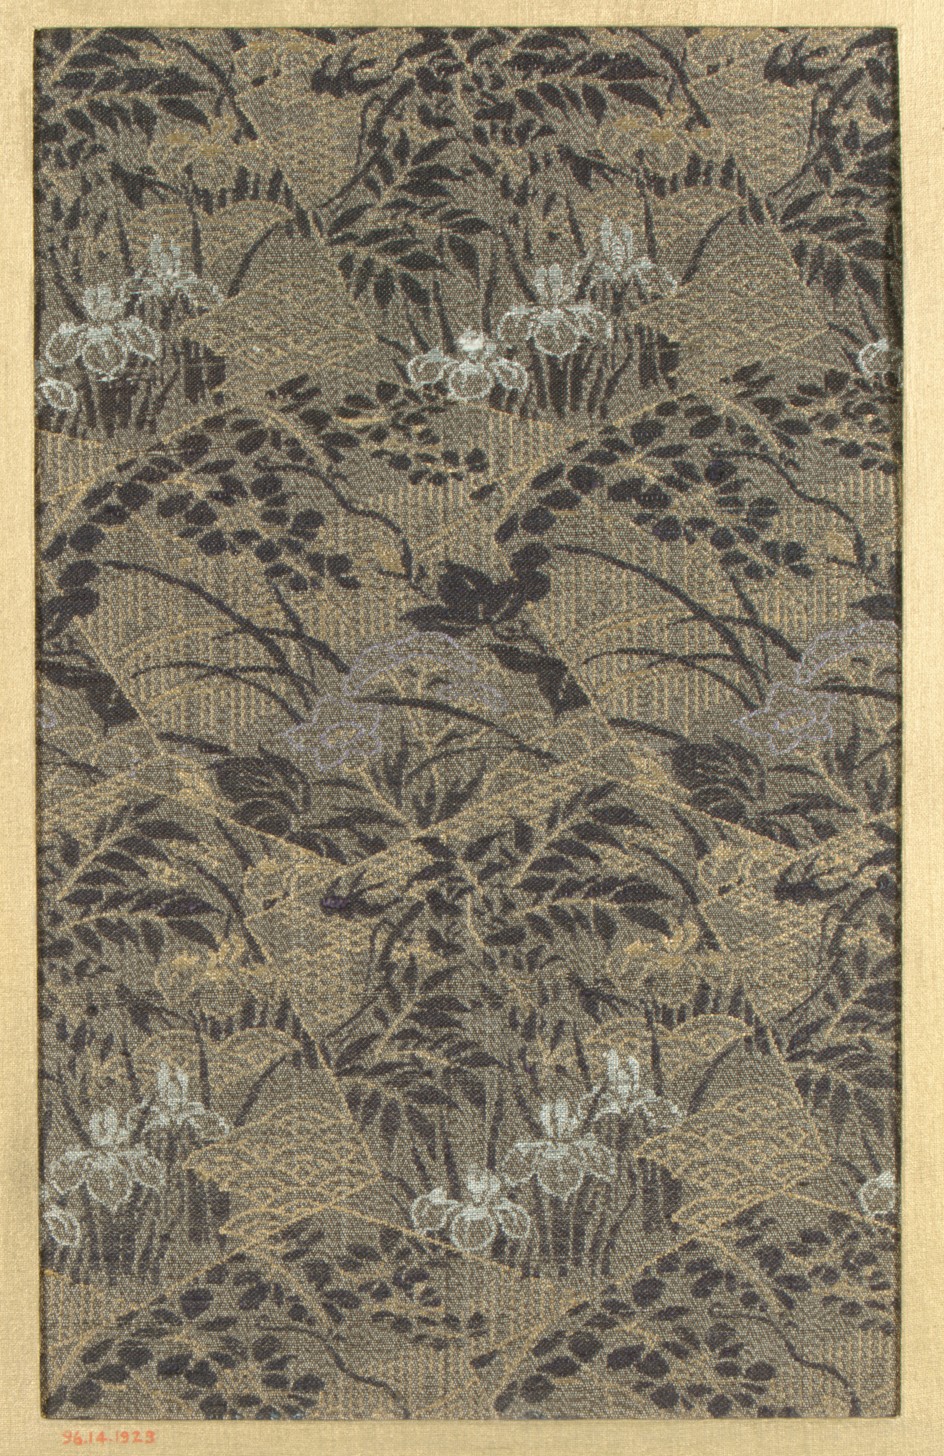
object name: piece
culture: japanese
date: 1701-1900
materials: silk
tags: flowers